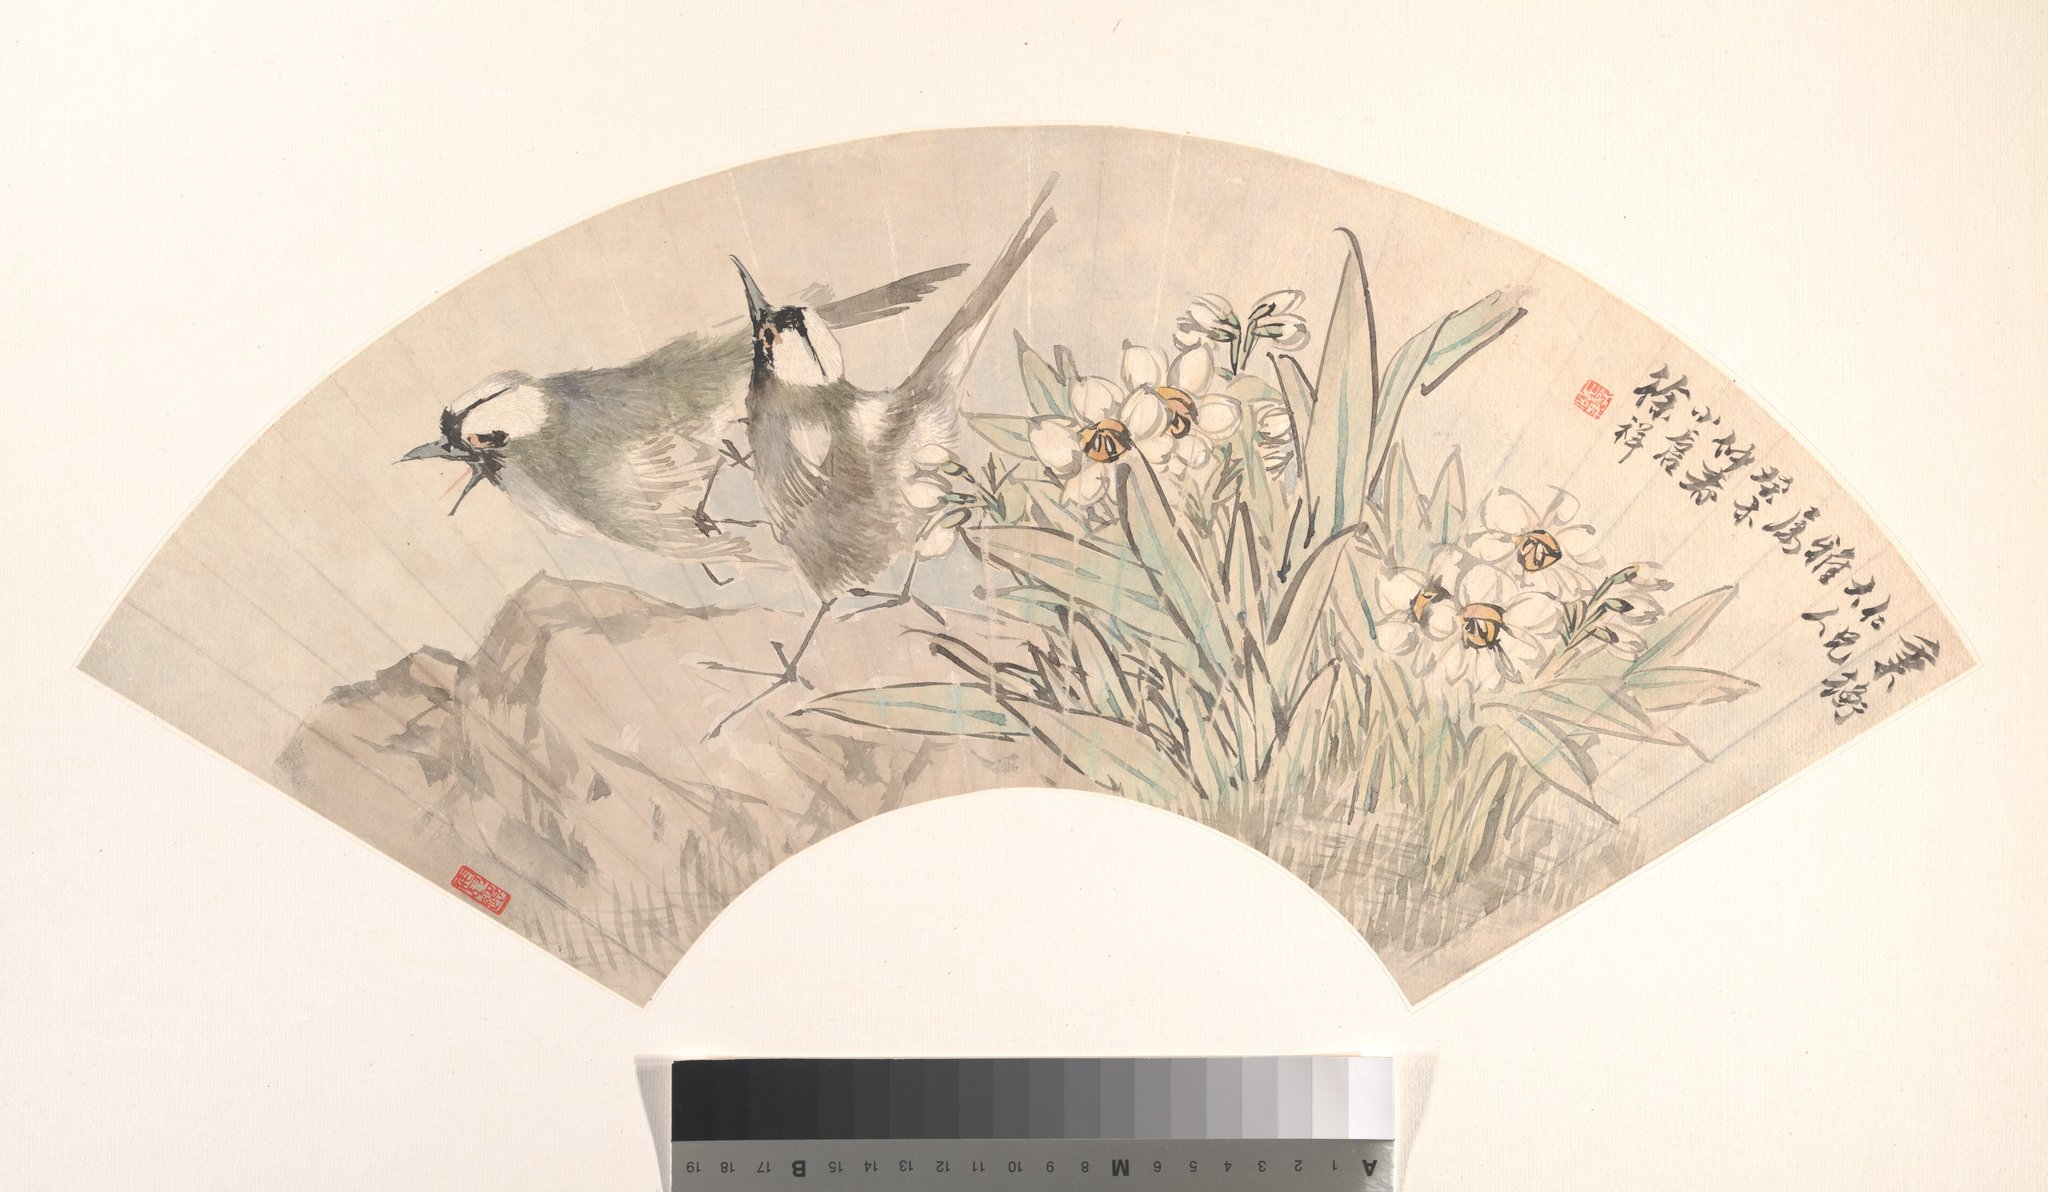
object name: folding fan mounted a an album leaf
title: Birds and Narcissus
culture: chinese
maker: xu xiang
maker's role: artist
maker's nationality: chinese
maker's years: 1850-1899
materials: ink, paper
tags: birds,narcissus